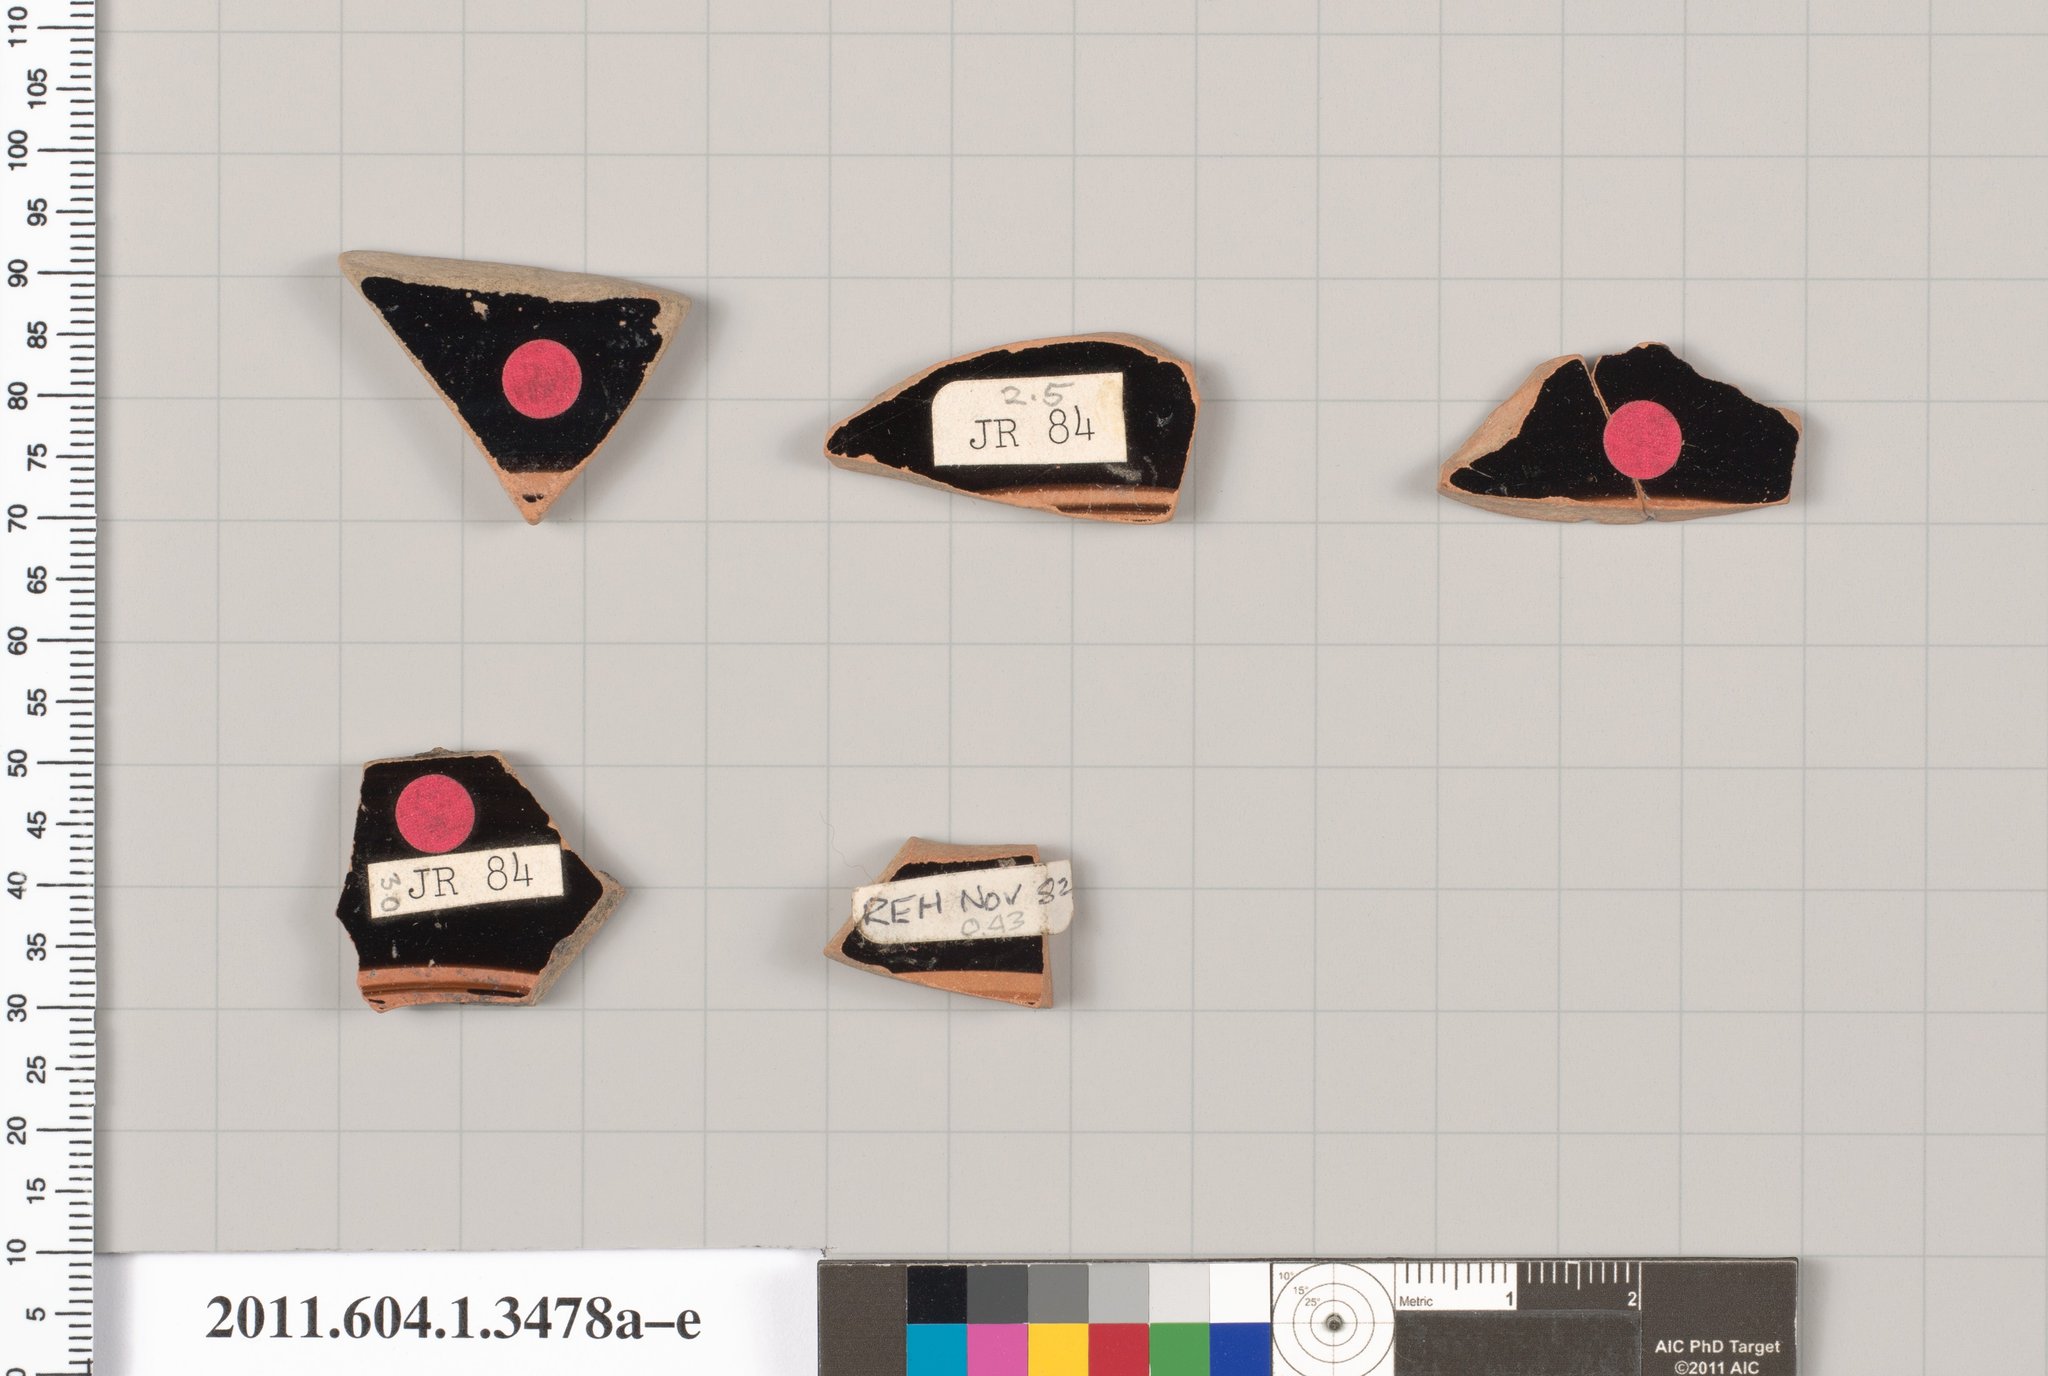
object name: kylix fragment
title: Terracotta fragments of kylikes (drinking cups)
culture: greek, attic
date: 500-475 BCE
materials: terracotta